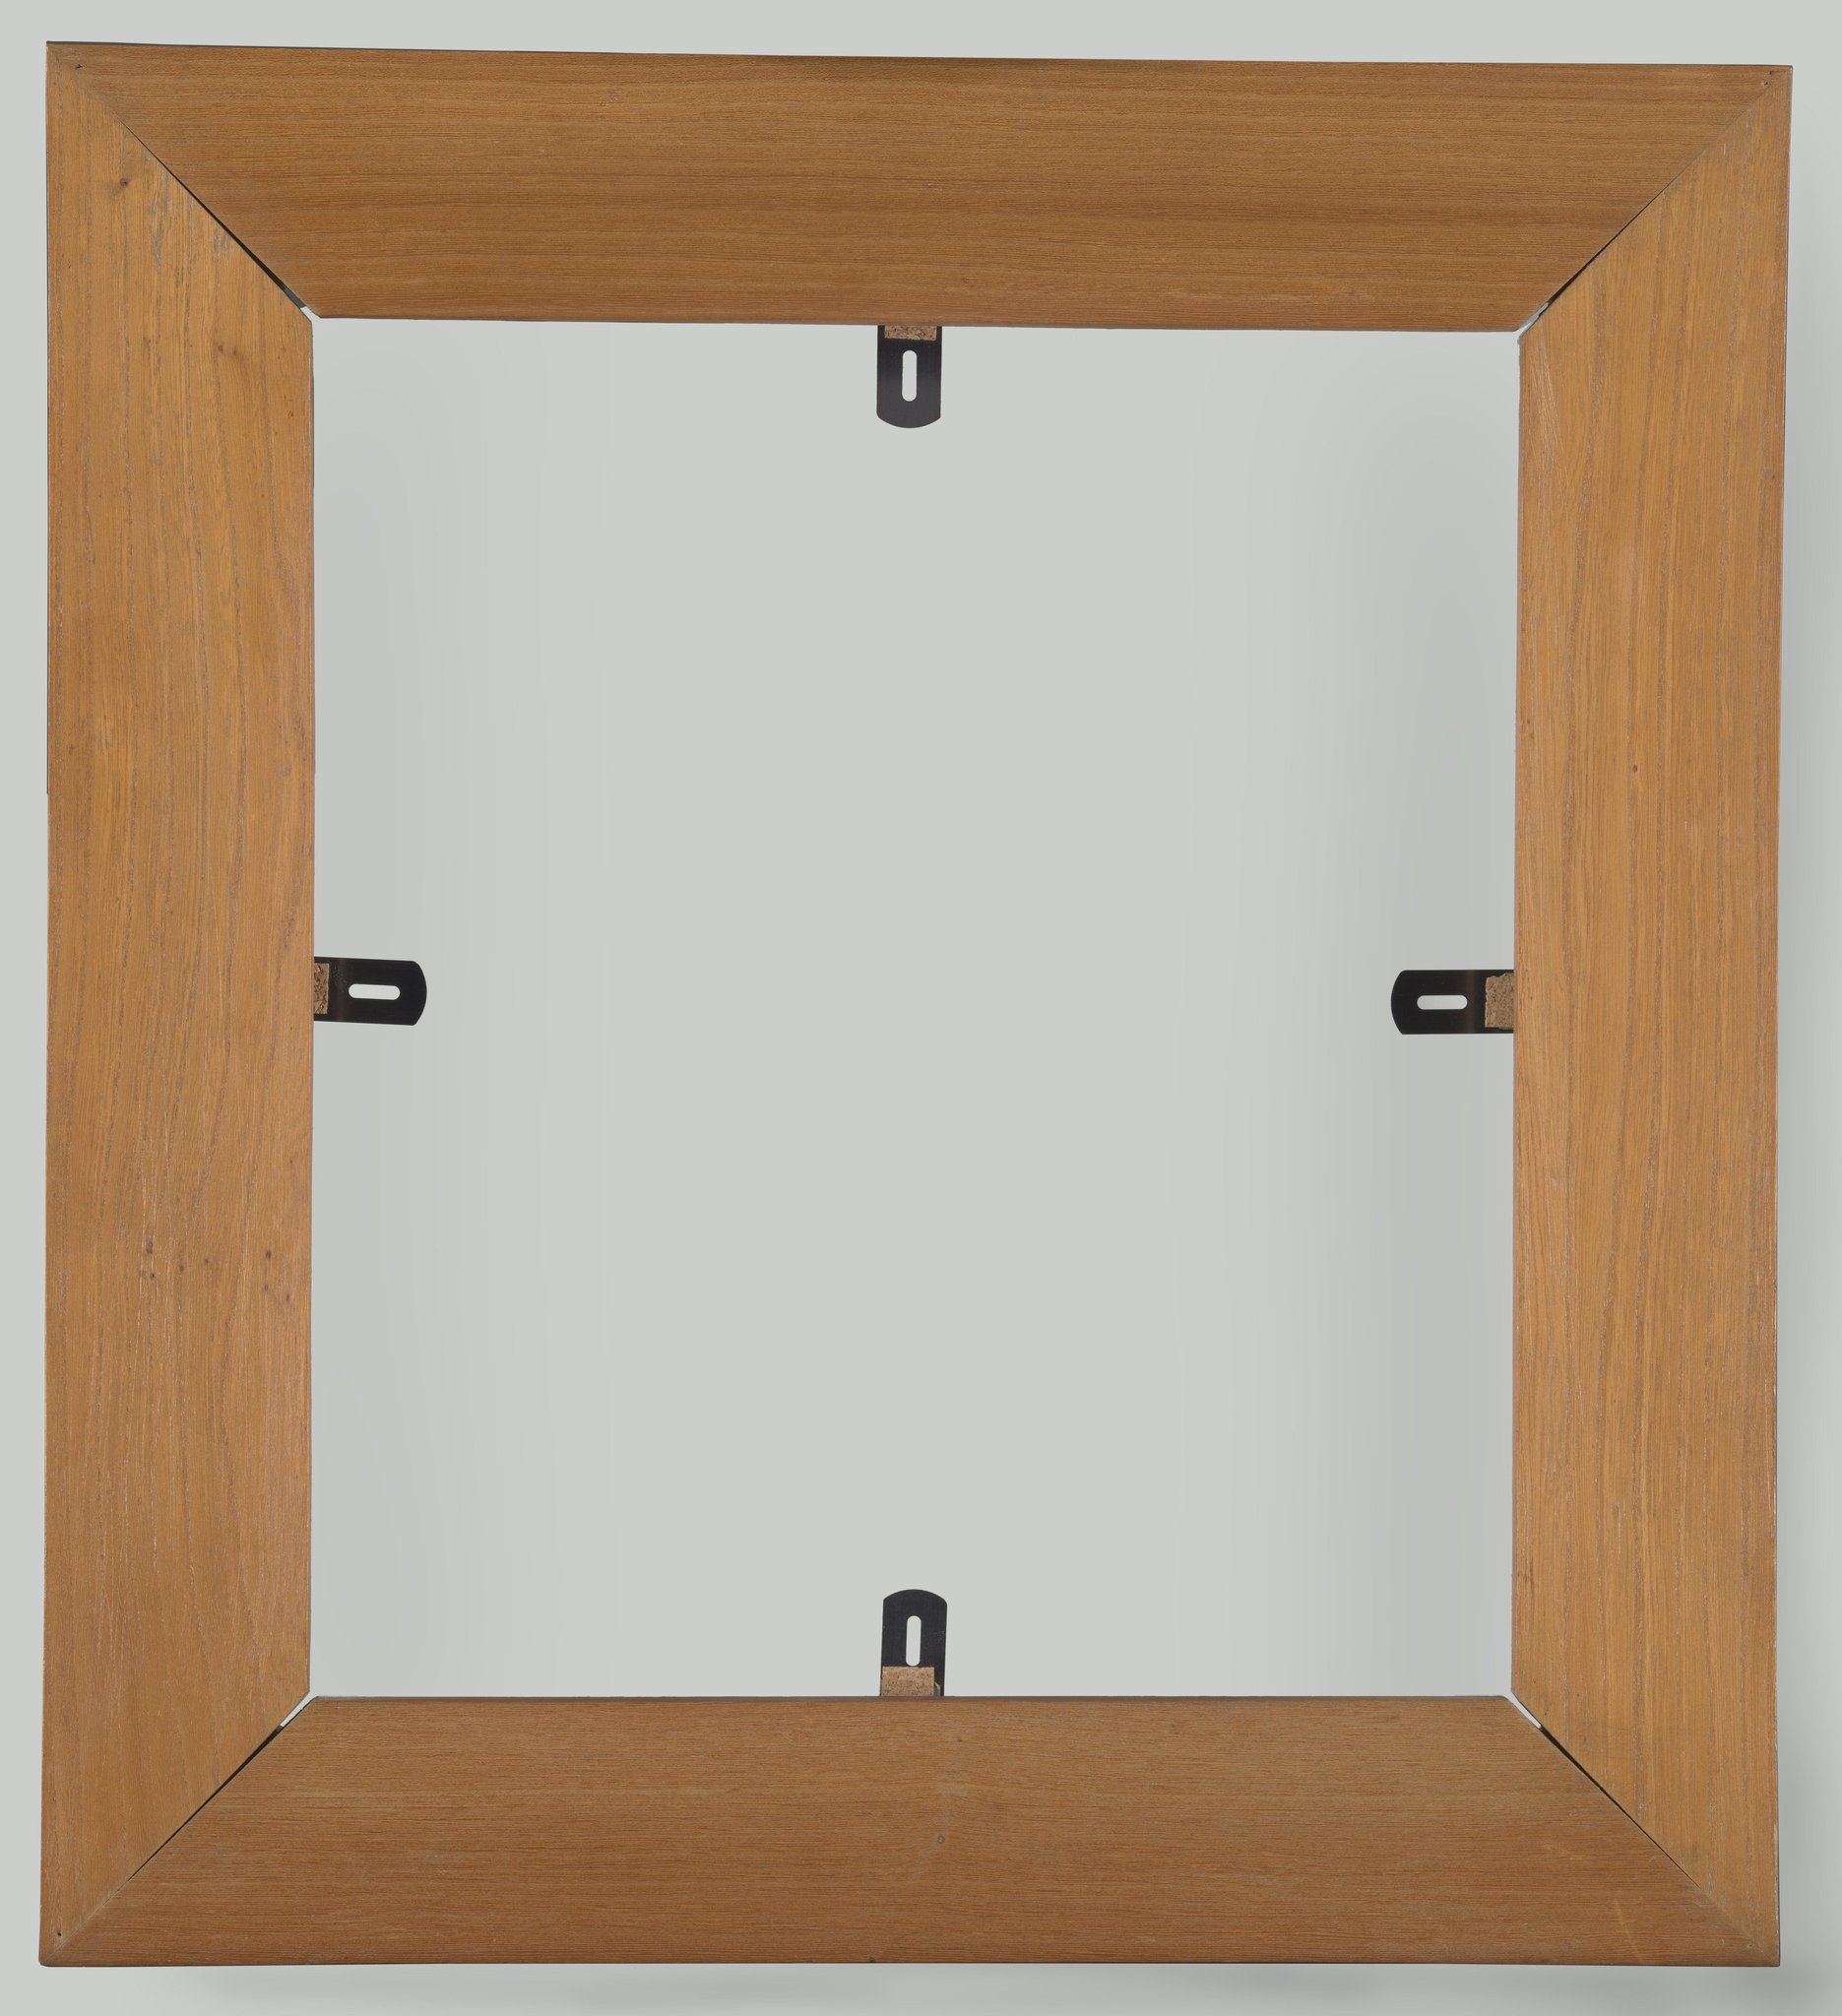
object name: frame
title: Ornamentloze houten lijst, oorspronkelijke lijst bij Charley Toorop, Zelfportret met bloemen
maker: Anonymous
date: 1933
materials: metal, wood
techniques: planed, sanding, sawing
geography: north holland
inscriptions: number: ‘4’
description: Brede, vlakke lijst, zonder ornament en zonder profiel, van onbehandeld hout. De hoeken zijn in verstek met elkaar verbonden door middel van ijzeren schroeven aan de achterzijde.